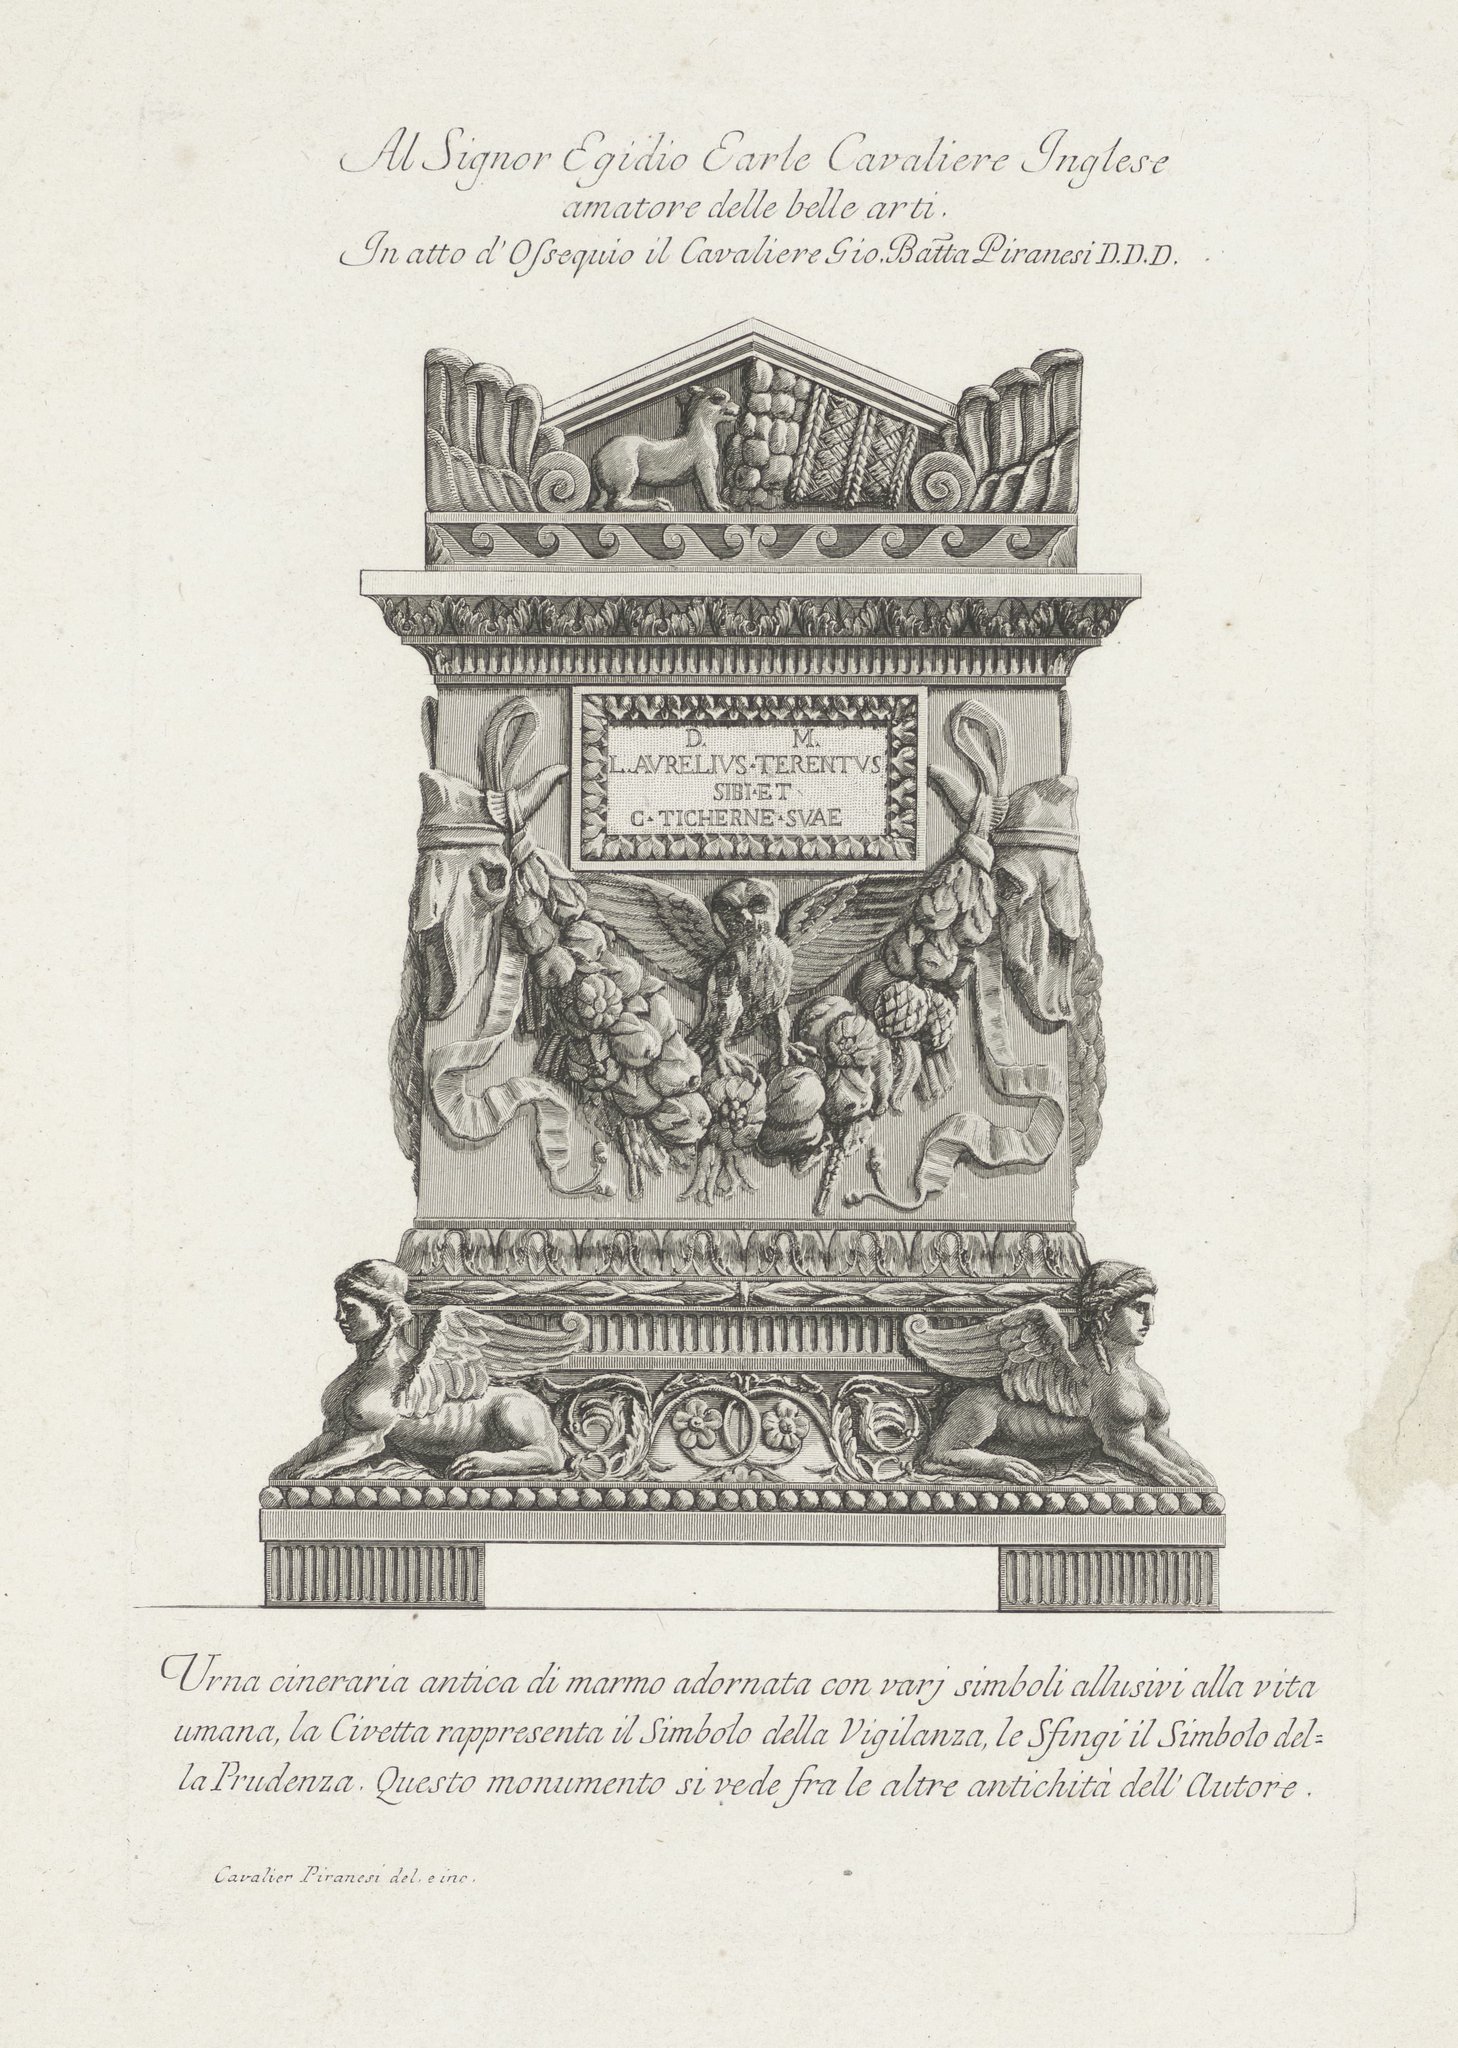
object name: print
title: Vasi, candelabri, cippi, sarcofagi, tripodi, lucerne, ed ornamenti antichi disegn. ed incisi dal cav. Gio. Batta Piranesi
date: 1778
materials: paper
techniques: etching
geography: rome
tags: sphinx (lion/woman); 'sfinge' (ripa) - aa - female human figure, vase ~ ornament, maenad(s), female bacchant(es), owls, urn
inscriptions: collector's mark: Lugt 2228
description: Blad met twee voorstellingen van een antieke asvaas en een urn. Links: een antieke urn met een uil op een guirlande, bucrania en sfinxen. Opdracht boven voorstelling. Tekst in ondermarge. Rechts: een antieke asvaas met een fries van Bacchanten. Opdracht boven voorstelling. Tekst in ondermarge.